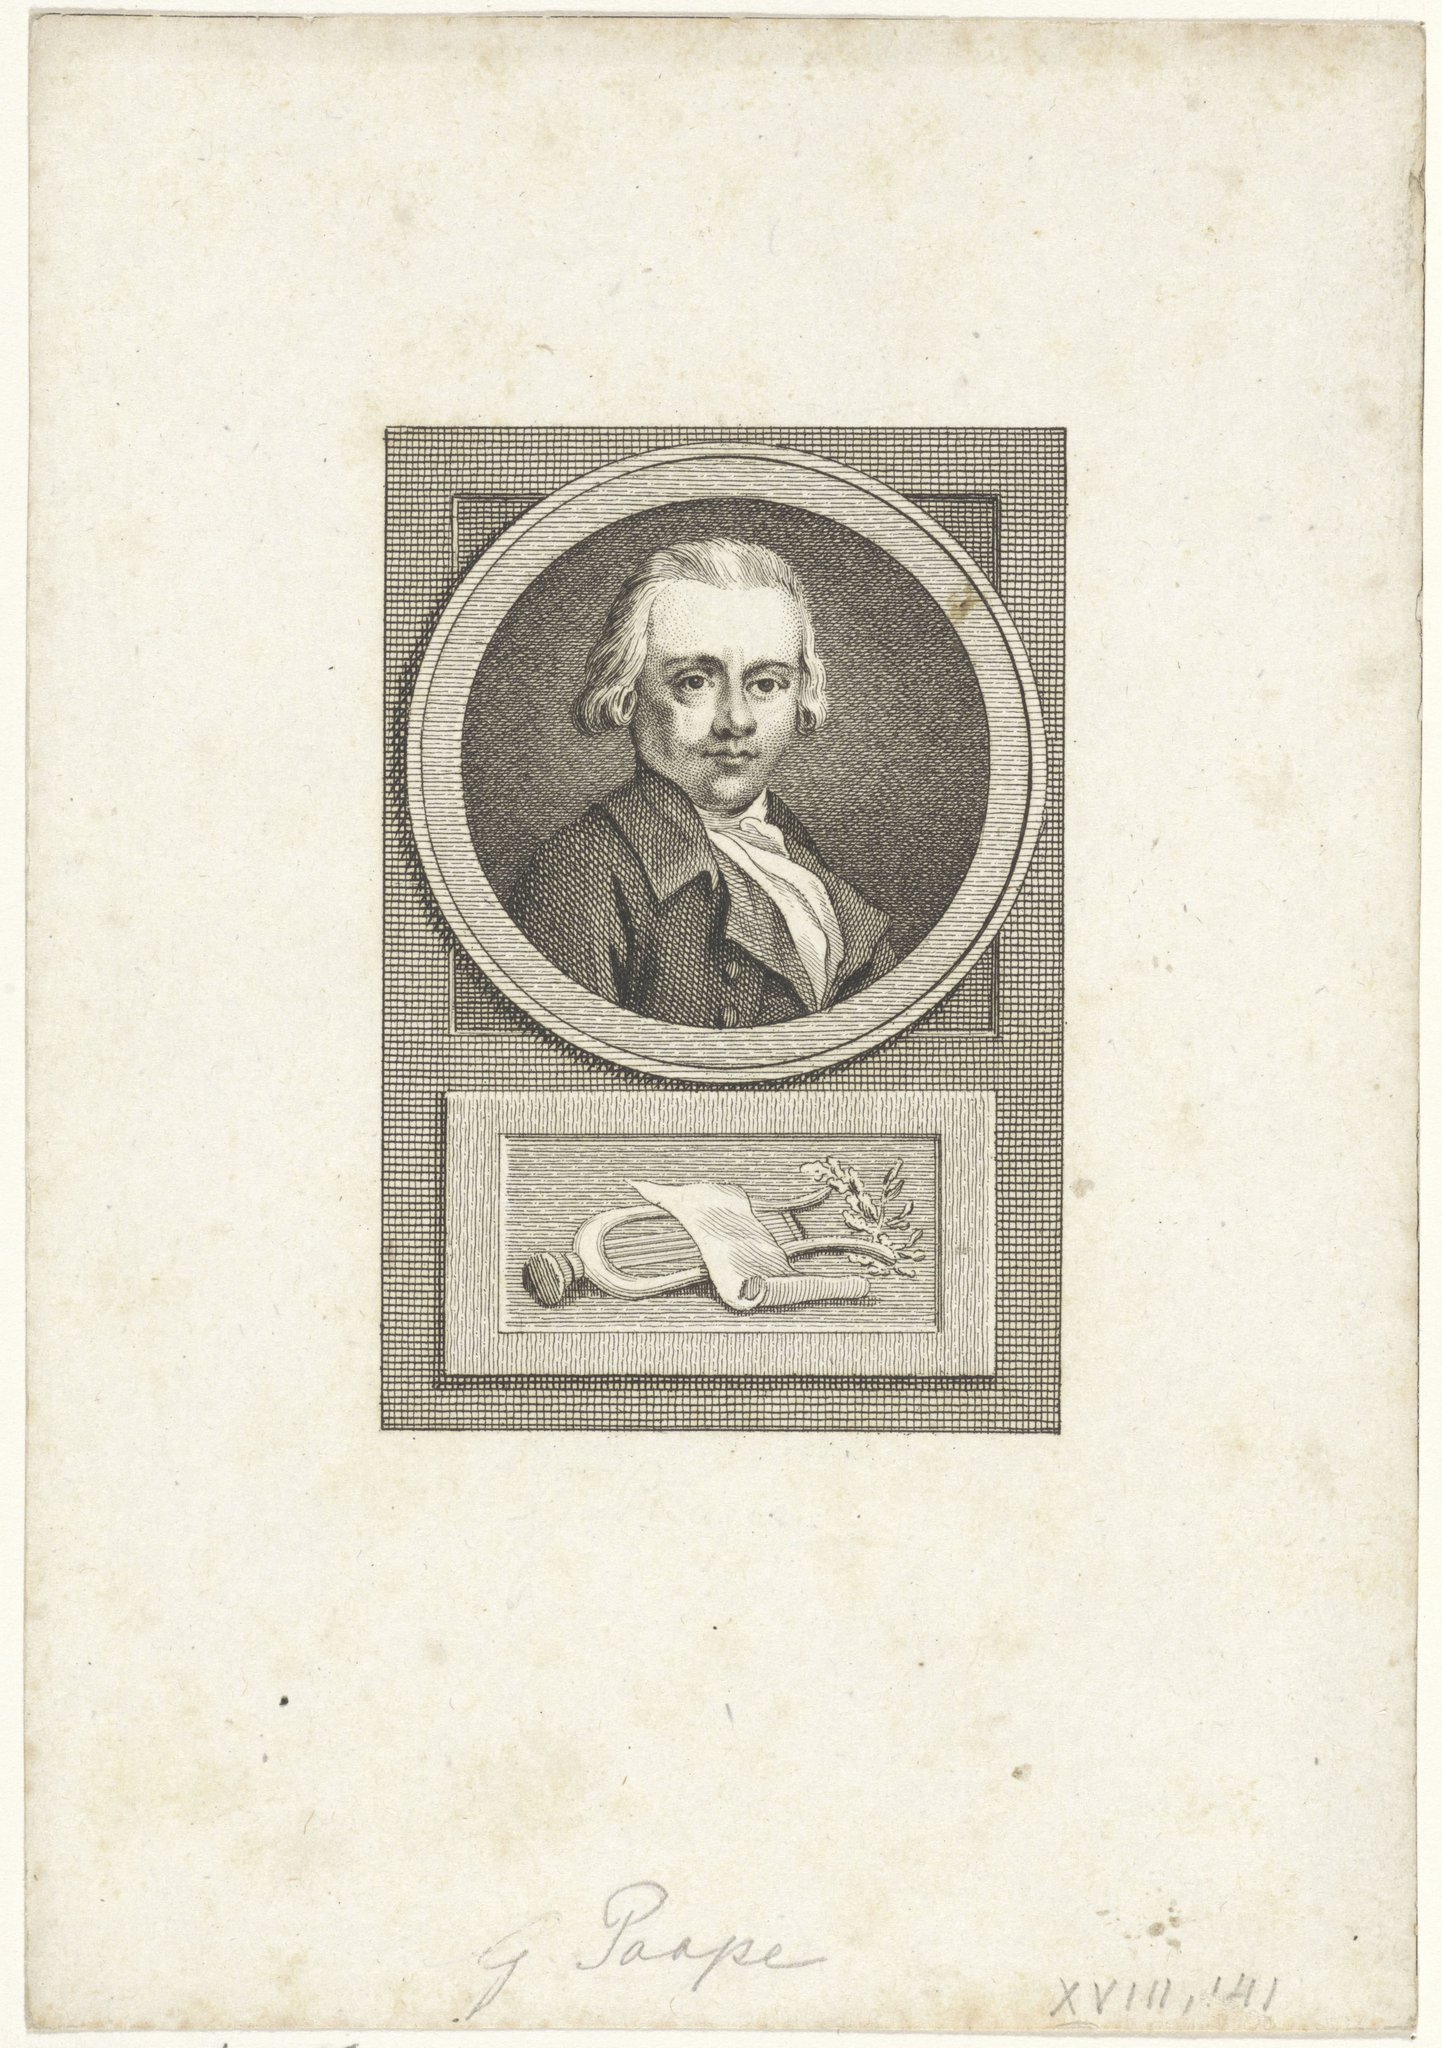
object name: print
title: Portret van Gerrit Paape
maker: reinier vinkeles (i)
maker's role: draughtsman, print maker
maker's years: 1741-1816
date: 1783-1795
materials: paper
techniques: engraving, etching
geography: amsterdam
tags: gerrit pape, lyre, cithara, psaltery, historical persons, paper (writing material)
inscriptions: collector's mark: Lugt 2228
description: Latere staat prent gebruikt in: Fokke, Jan. Geschiedenissen der Vereenigde Nederlanden voor de vaderlandsche jeugd Ie-XXVste deel. Amsterdam: Johannes Allart, 1783-1795. Deel XVIII.